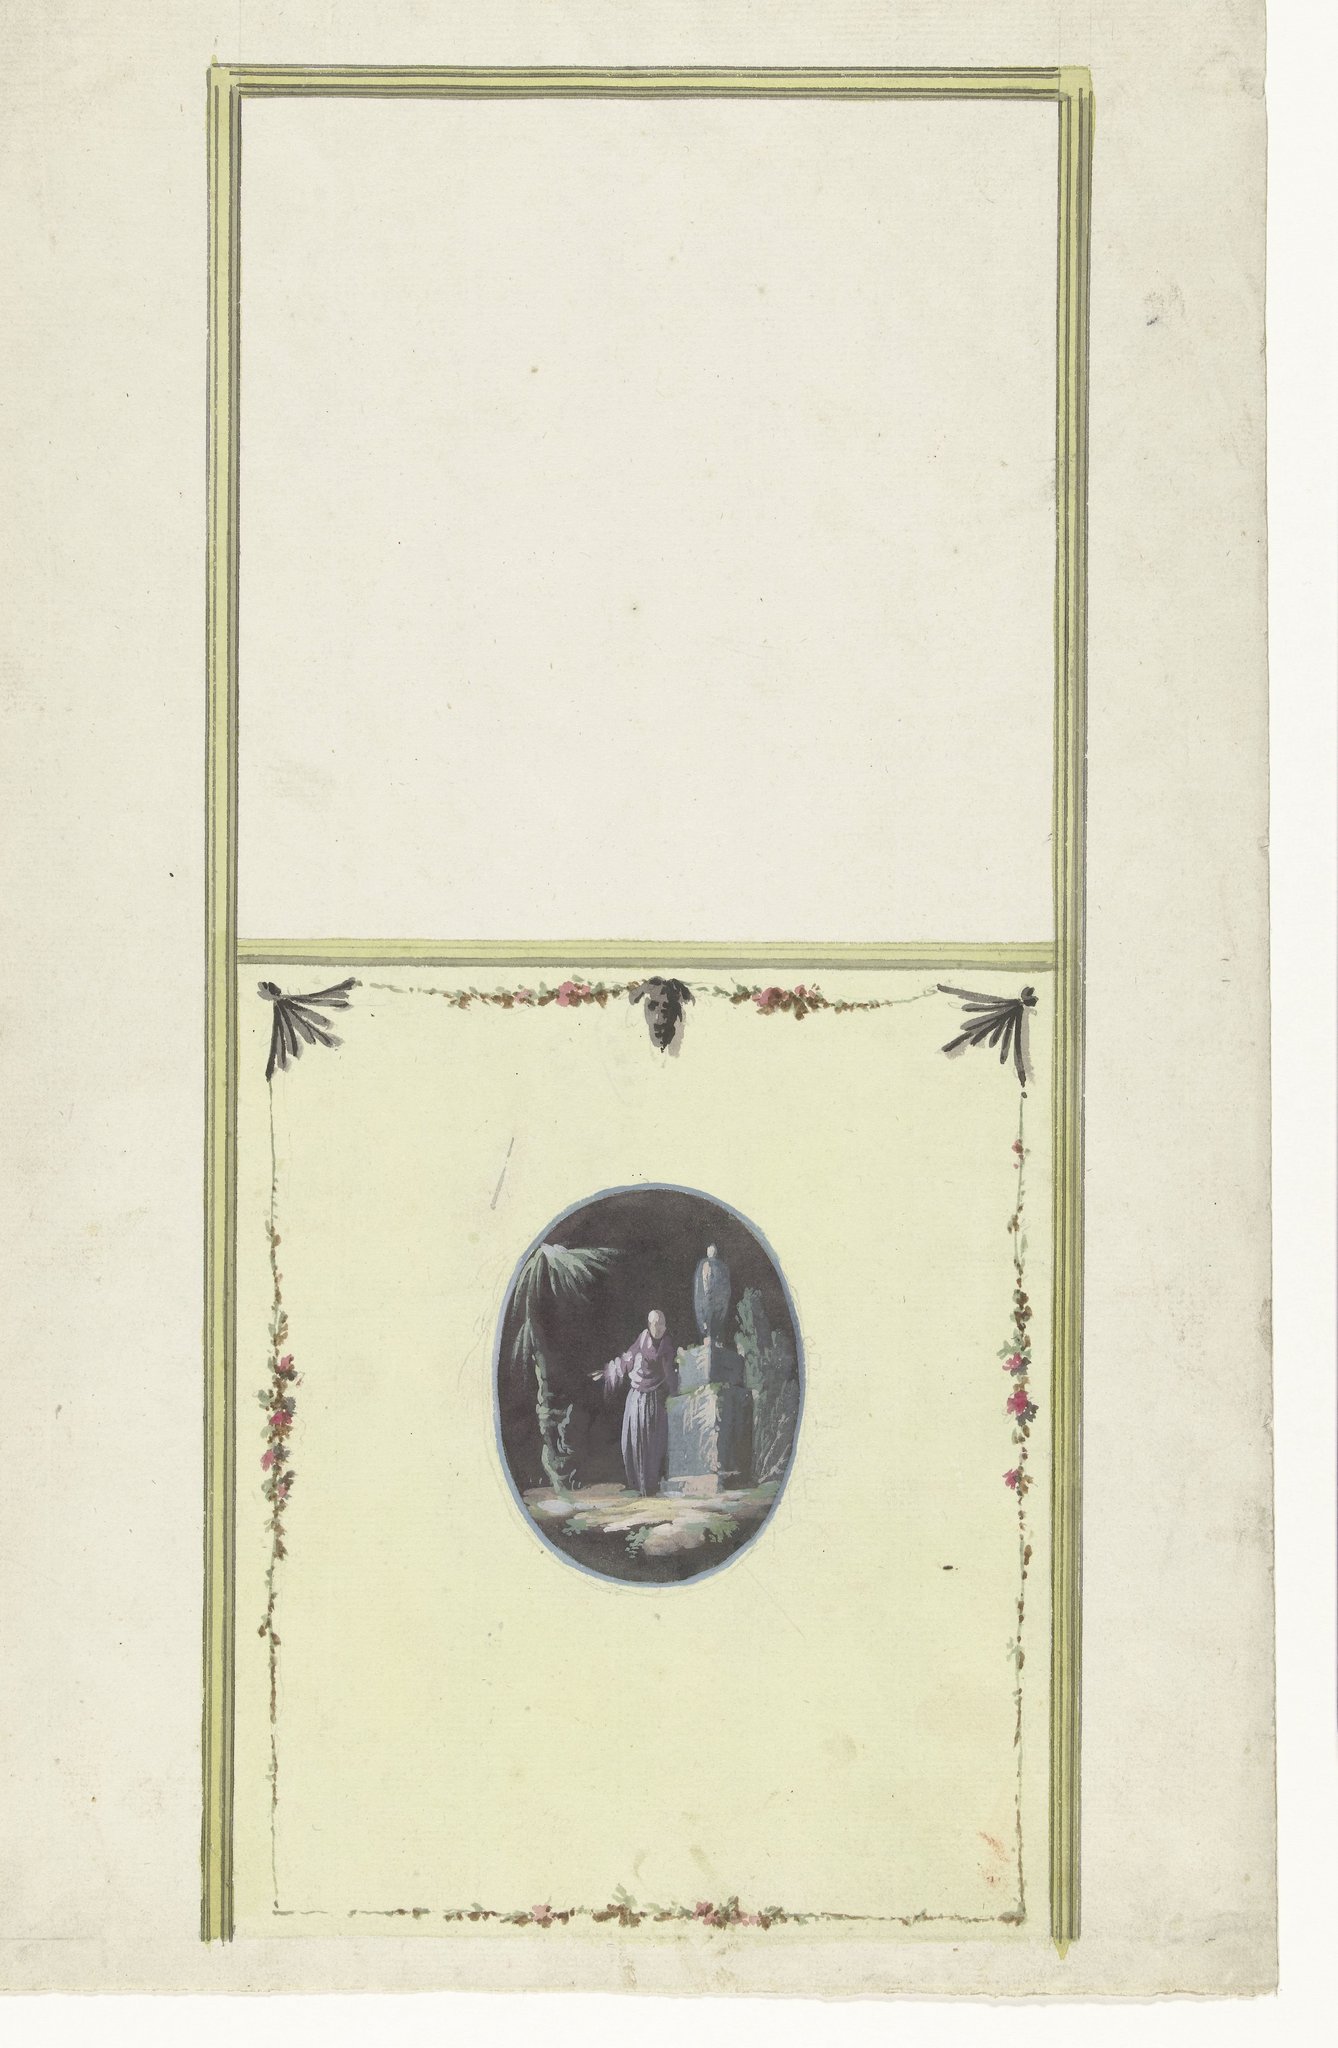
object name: drawing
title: Ontwerp voor kamerversiering met verticaal twee panelen, de onderste met een chinoiserie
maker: abraham meertens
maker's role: draughtsman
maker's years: 1757-1823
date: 1767-1823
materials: paint, ink, paper, pencil, watercolor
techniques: brush, pen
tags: wall-covering